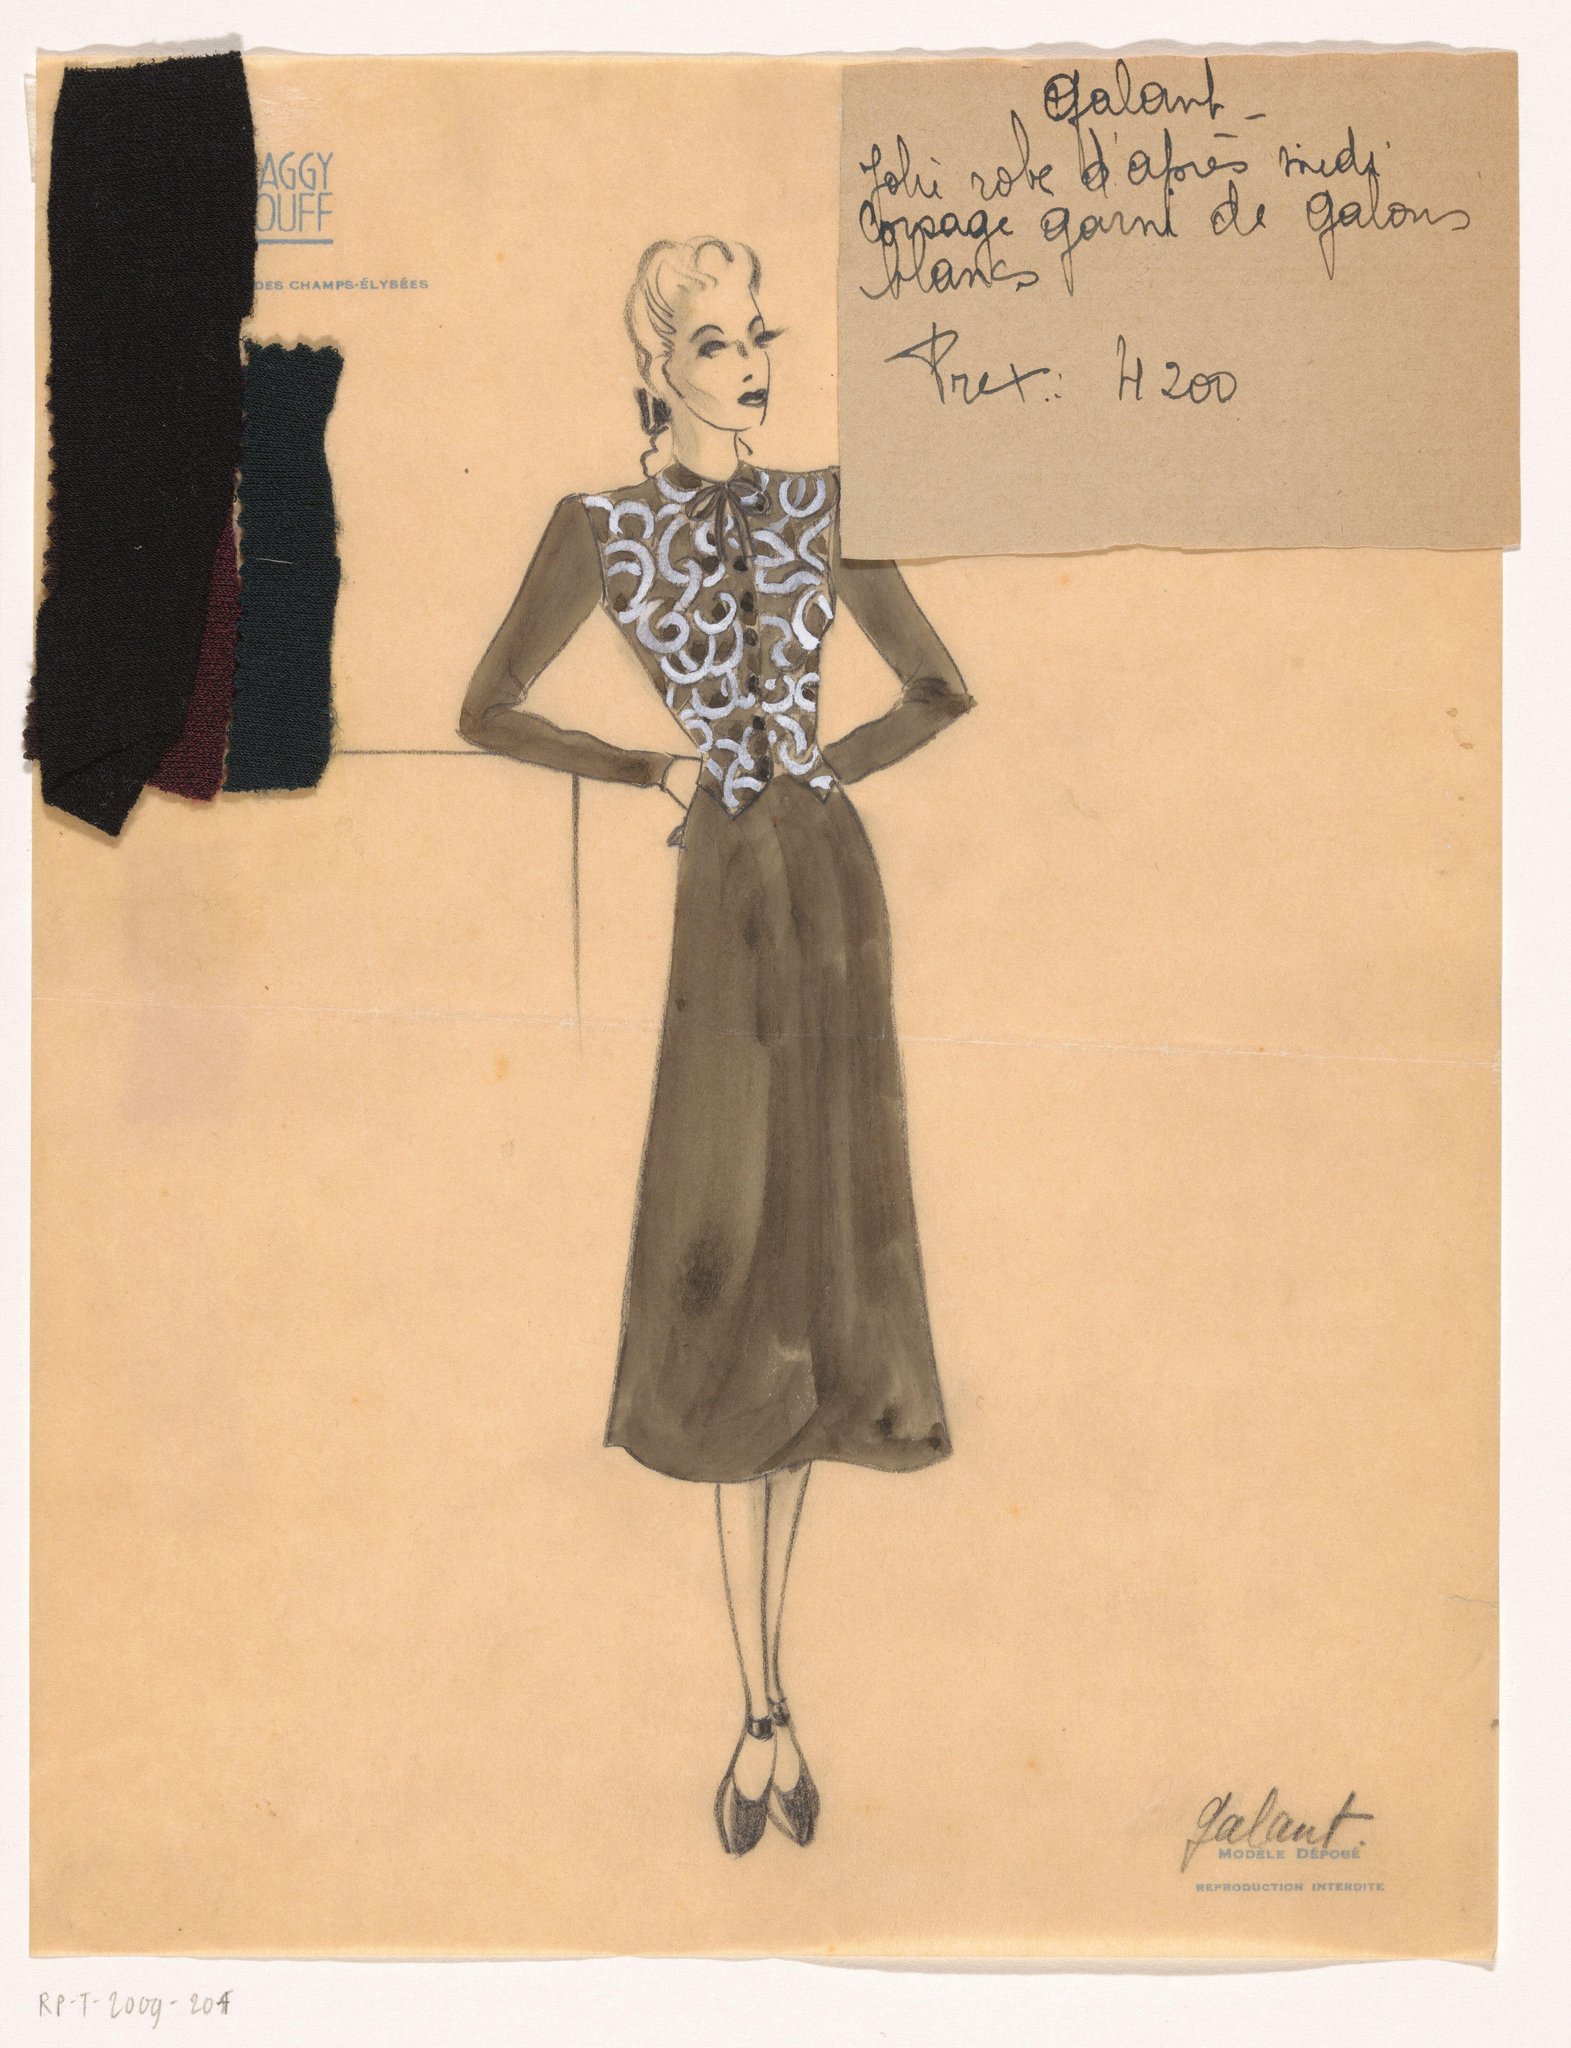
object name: fashion plate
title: Maggy Rouff: Gallant. Jolie robe d'après midi. Corsage garni de gallons blancs.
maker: maggy rouff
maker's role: modeontwerper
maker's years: 1896-1971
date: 1938-1939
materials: paper, pencil, watercolor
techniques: brush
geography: paris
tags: dress, gown: evening dress (+ women's clothes), fashion plates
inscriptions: title: ‘Gallant. Jolie robe d'après midi. Corsage garni de gallons blancs.’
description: Middagjapon van Maggy Rouff. Het lijfje is gegarneerd met wit belegsel, de rok valt net onder de knie. Linksboven twee staaltjes zwarte stof. Prijs: 4200,- Frs.